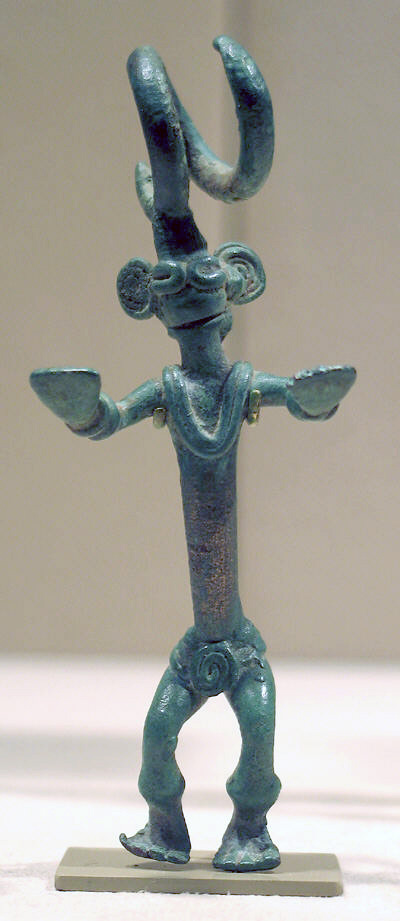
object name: figure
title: Anthropomorphic Figure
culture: indonesian, sumatran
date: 500 BCE-300 CE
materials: bronze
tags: mythical creatures